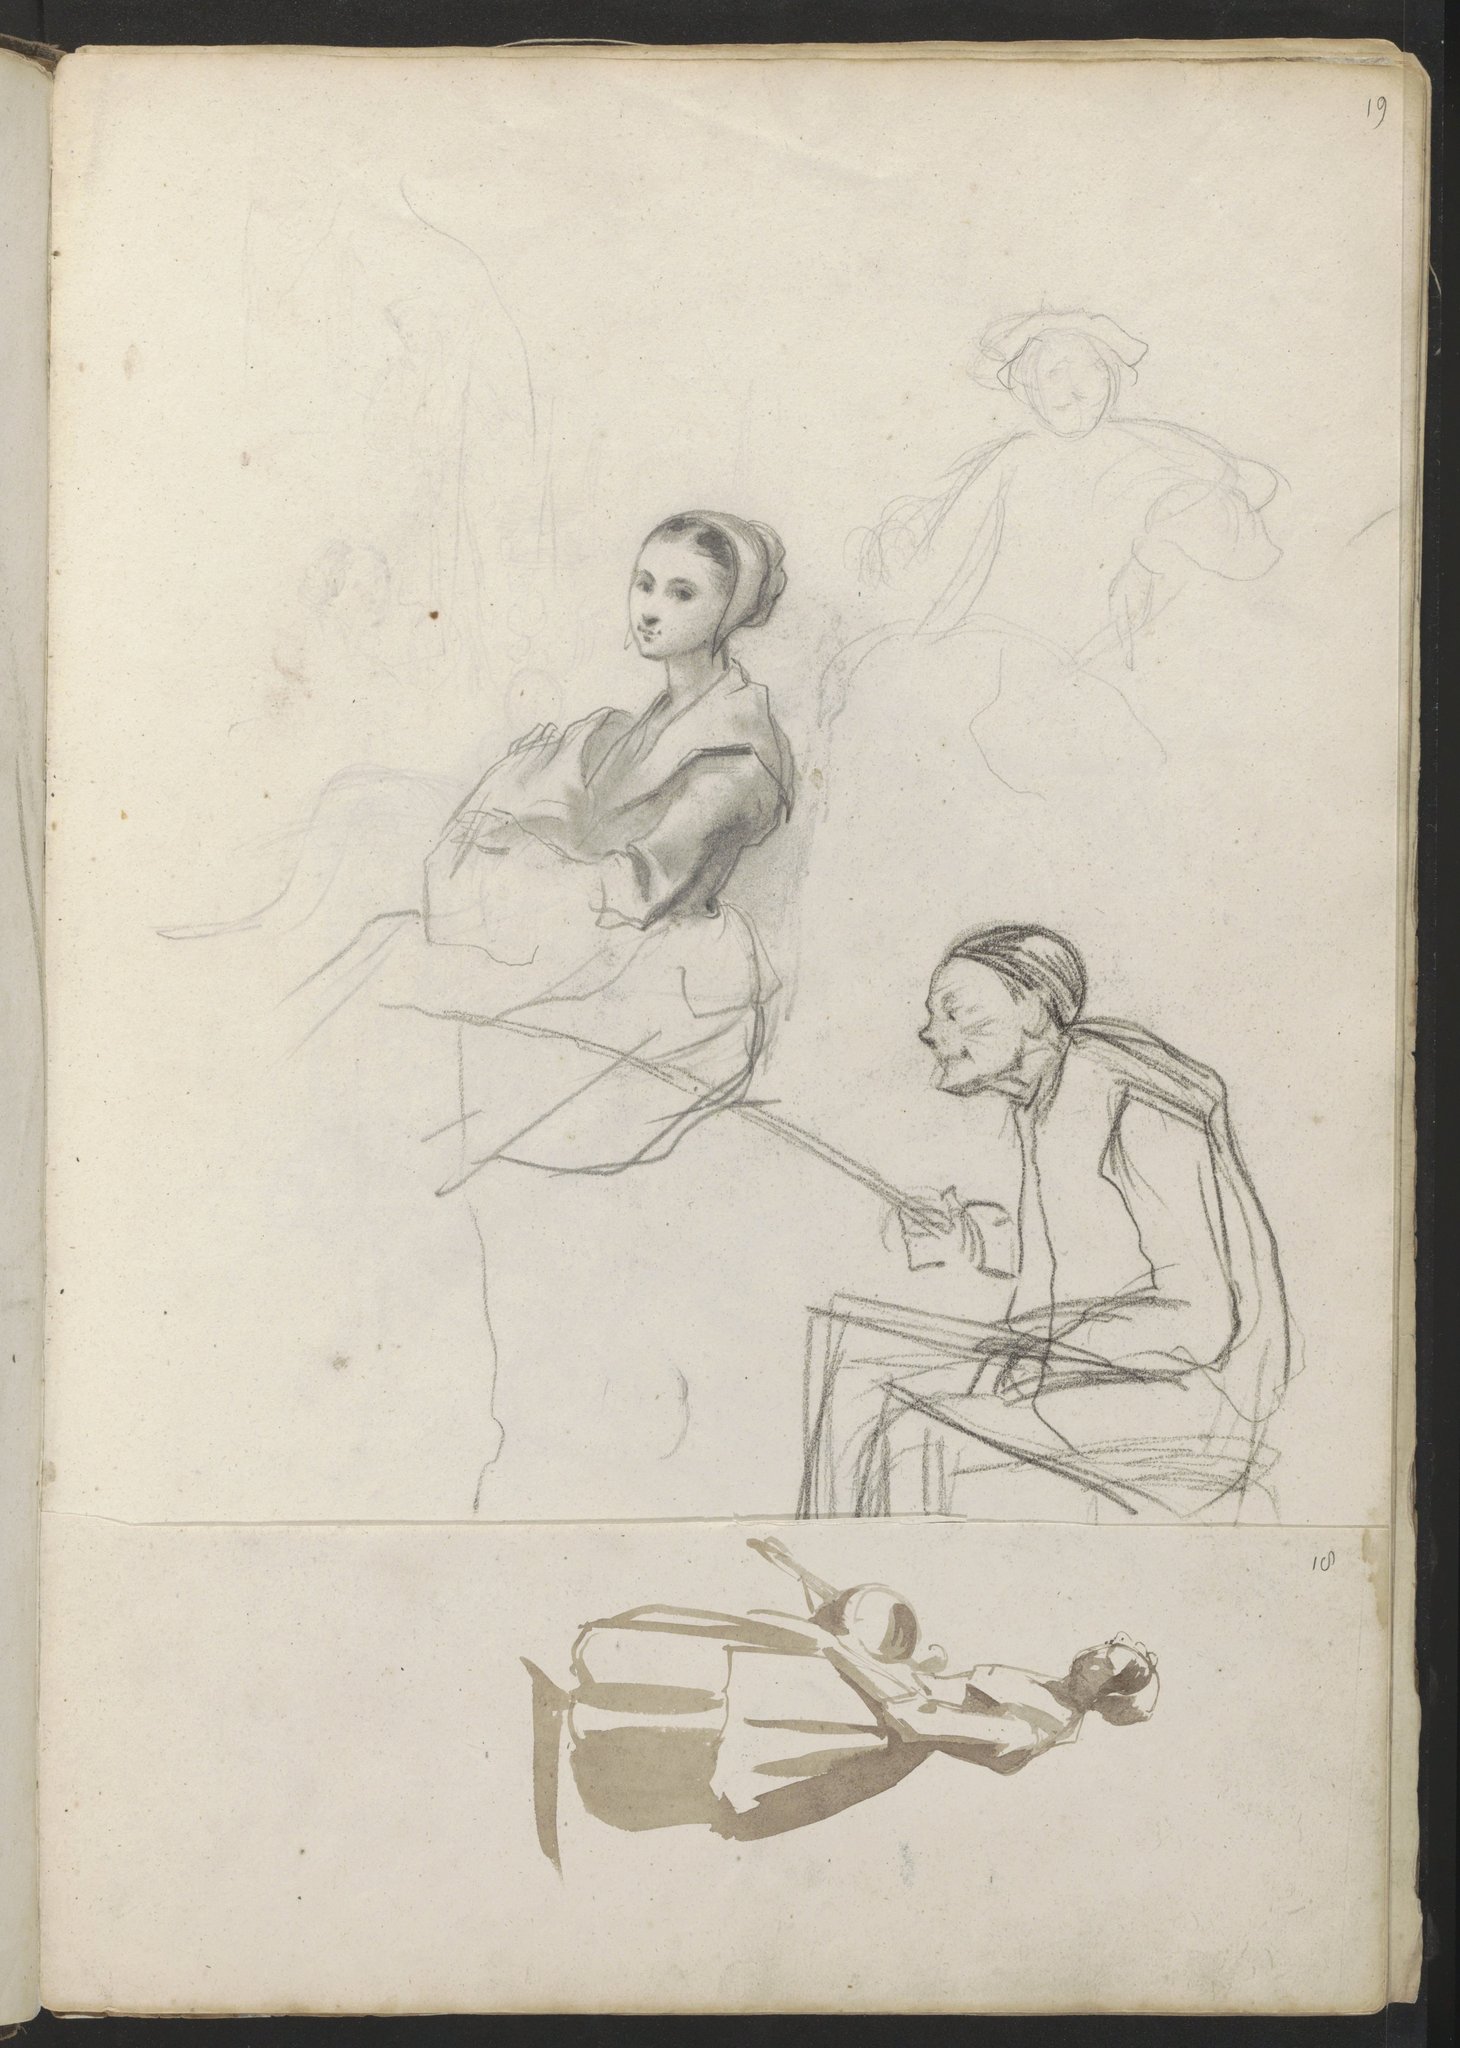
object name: sketchbook leaf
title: Vrouw met een gieter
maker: johannes huybertus van hove bzn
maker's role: print maker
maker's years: 1827-1881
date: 1837-1881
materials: ink, paper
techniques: brush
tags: adult woman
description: Blad 18 recto uit een schetsboek met 33 bladen en 10 losse tekeningen.